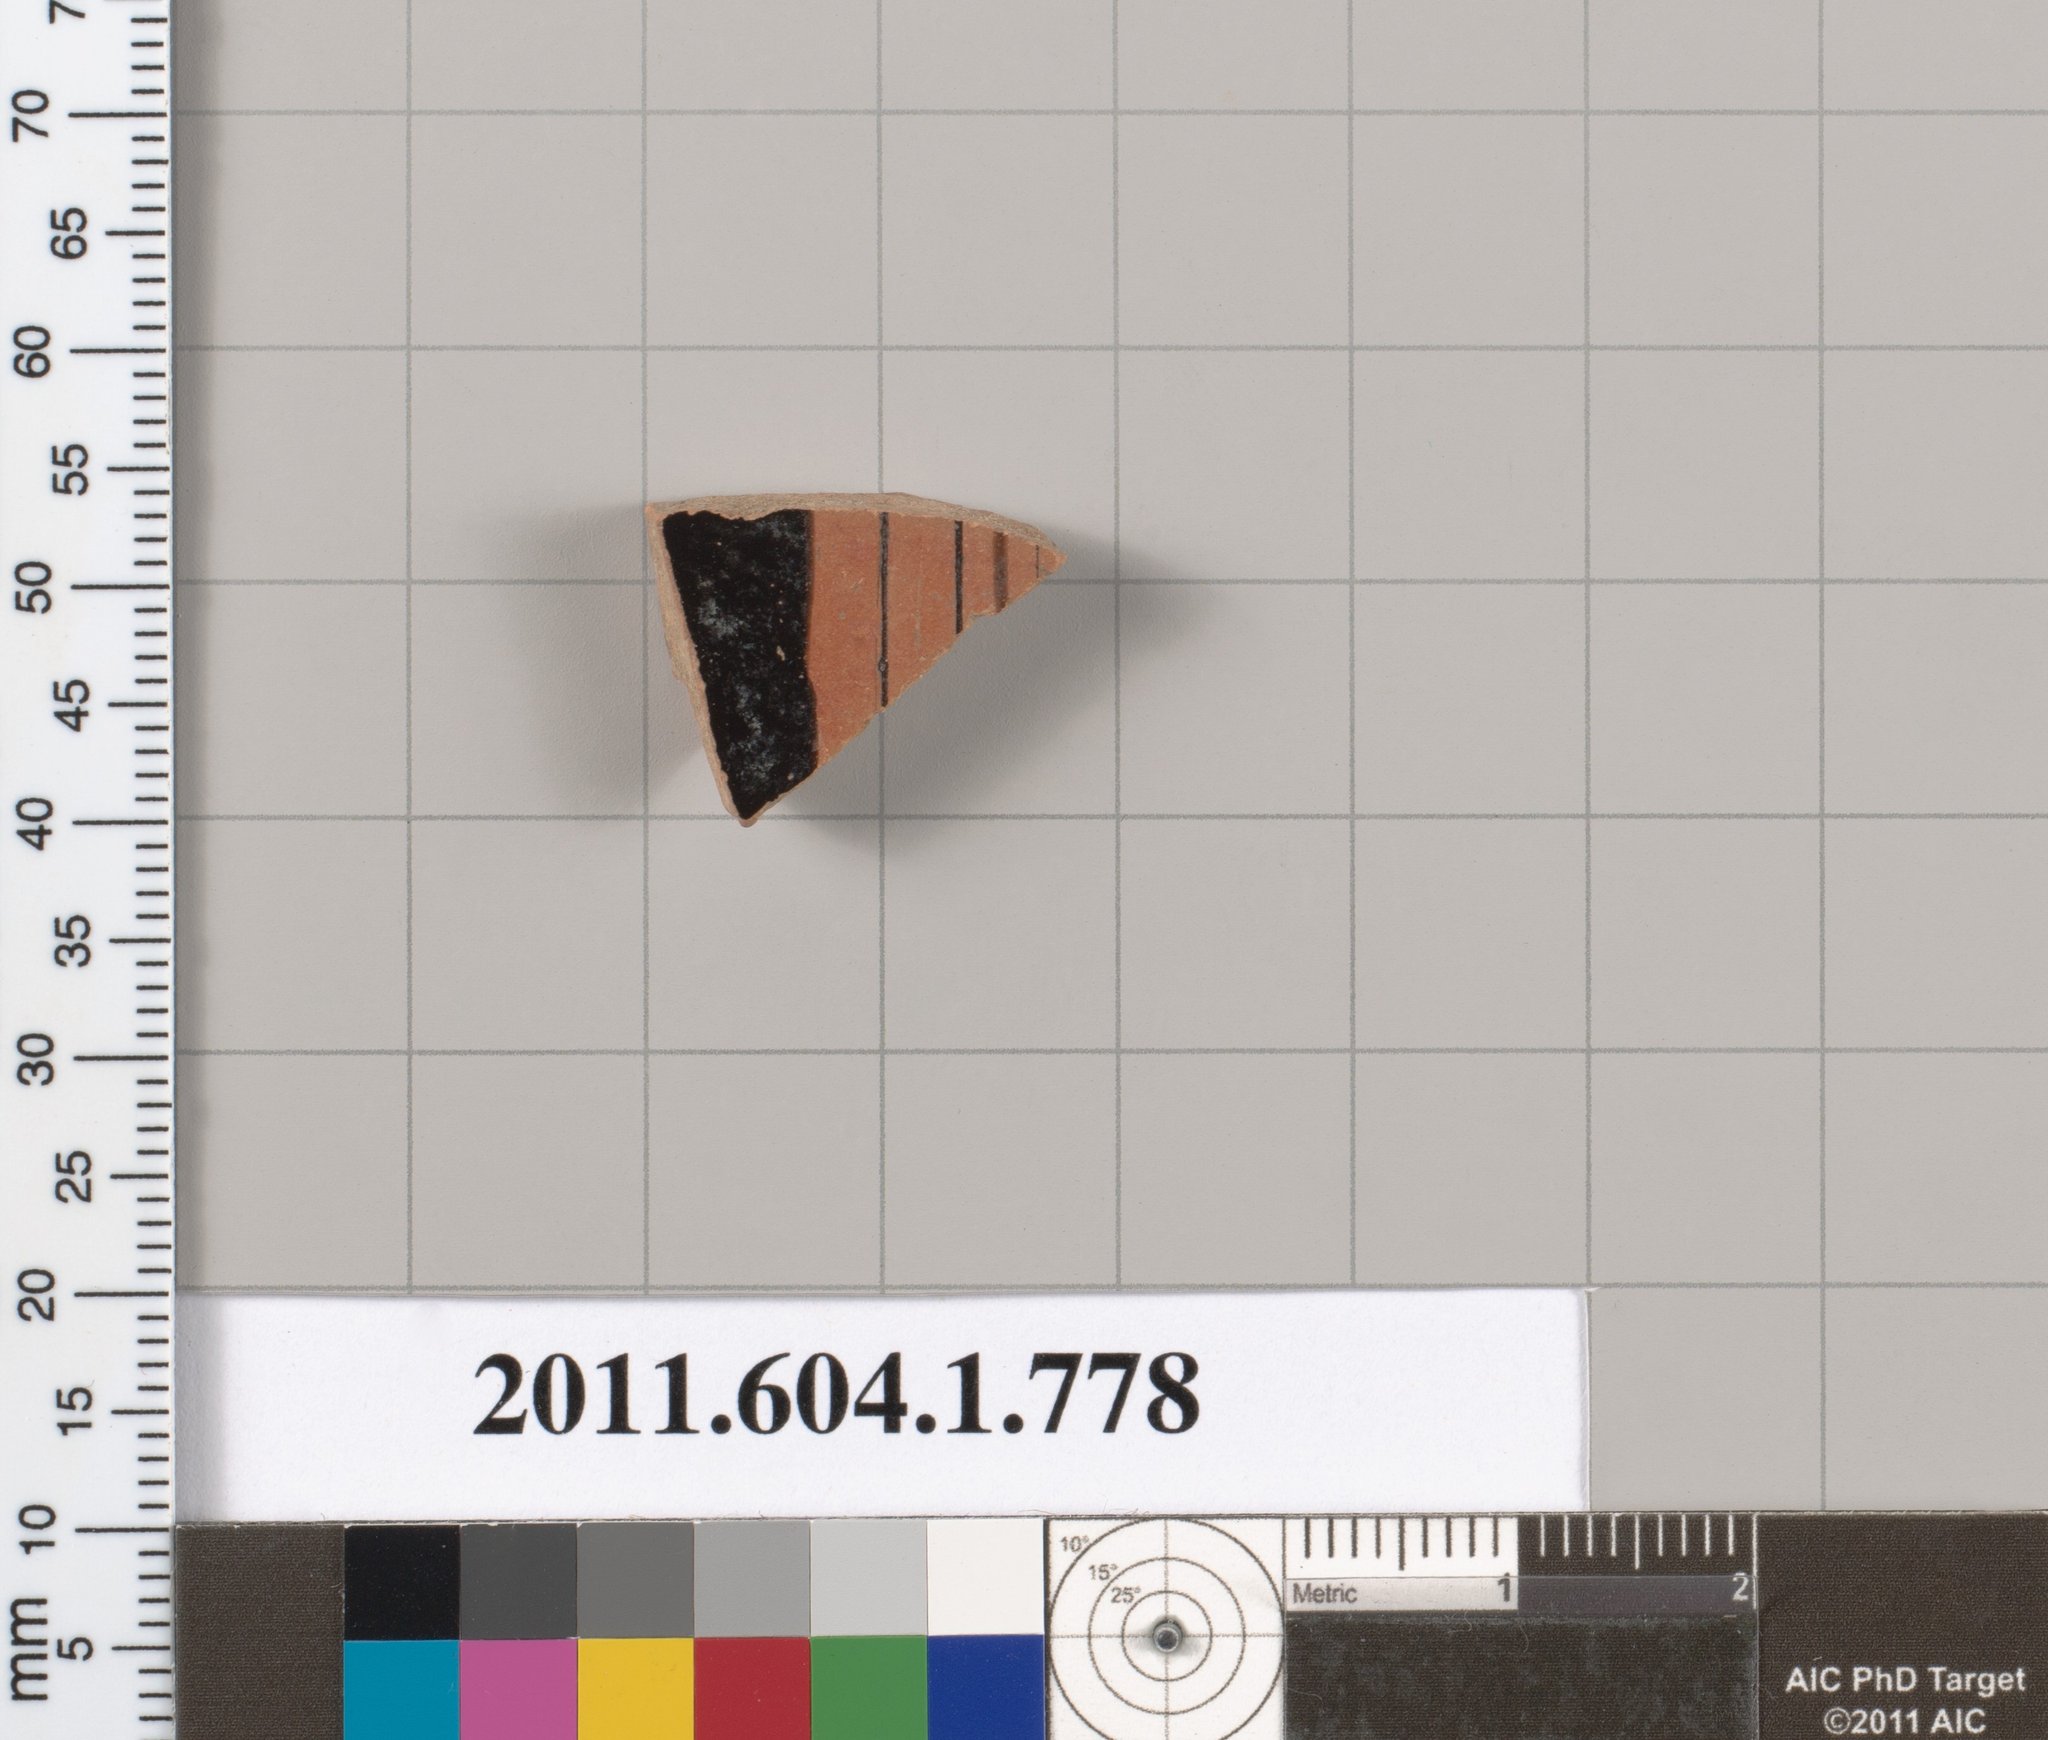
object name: kylix fragment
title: Terracotta fragment of a kylix (drinking cup)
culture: greek, attic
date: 475-451 BCE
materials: terracotta